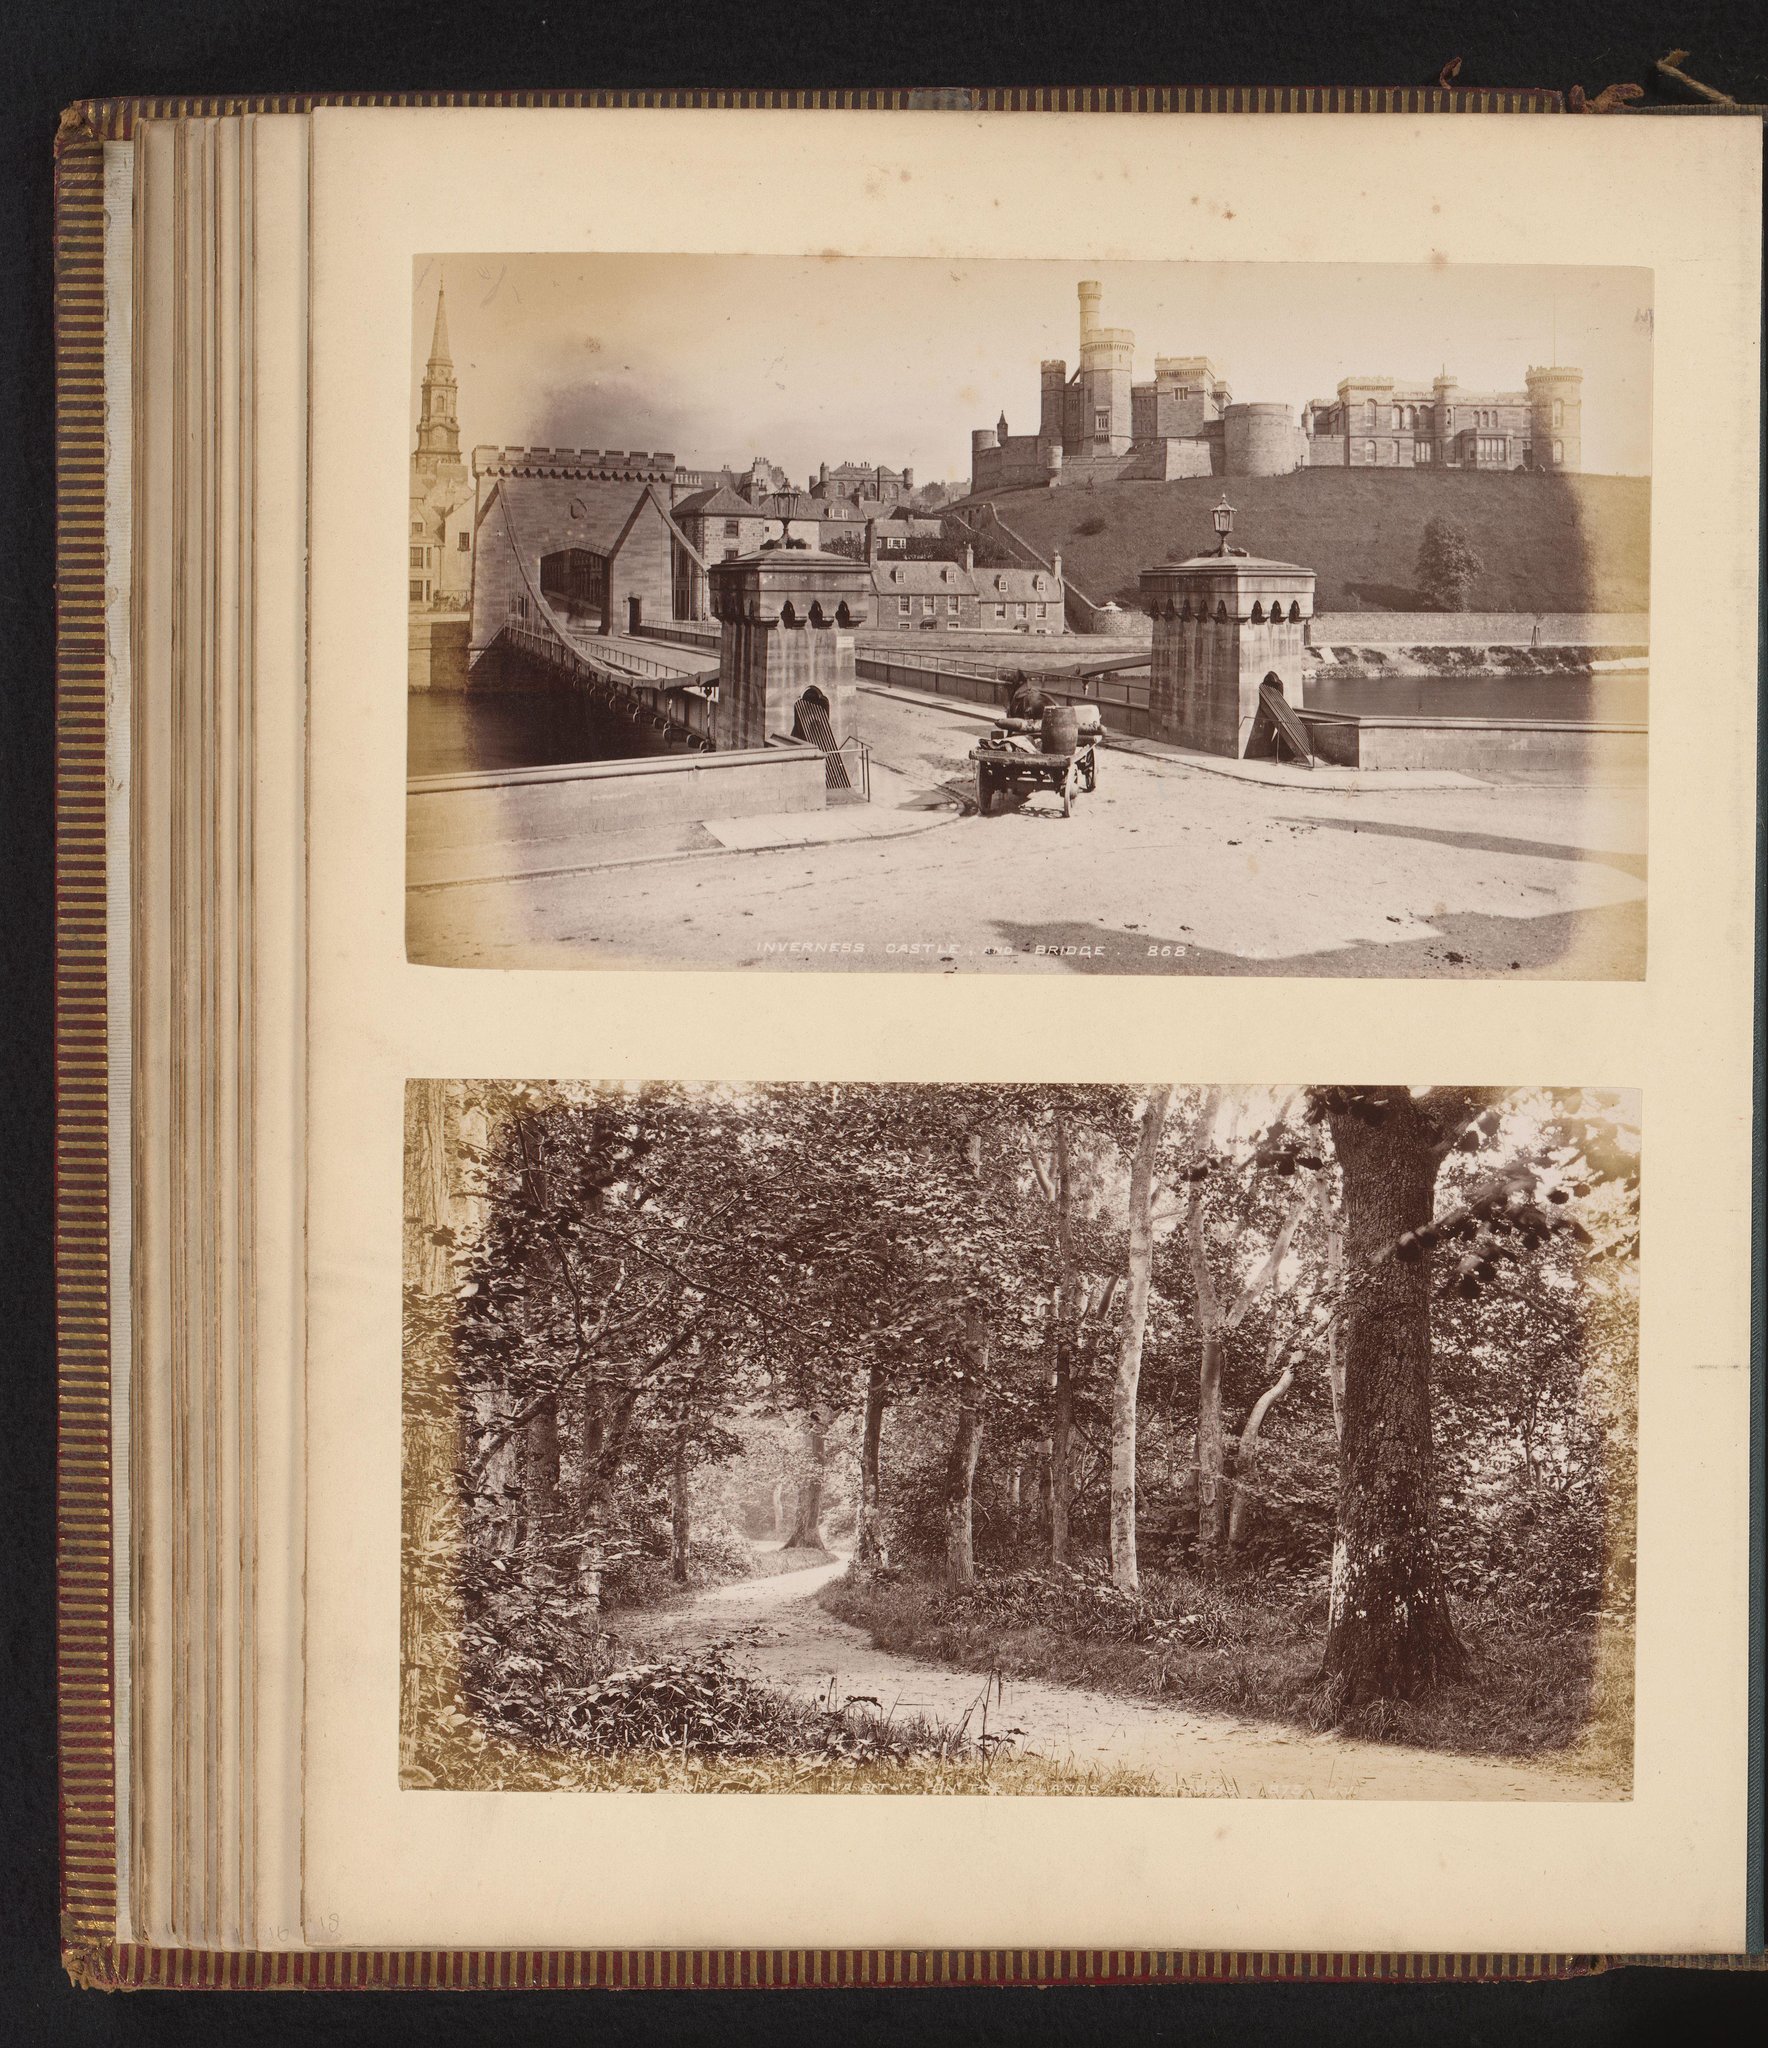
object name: album leaf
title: Inverness Castle en Gezicht op een bospad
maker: Anonymous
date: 1875-1885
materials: photographic support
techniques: albumen print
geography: inverness castle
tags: castle, forest path or lane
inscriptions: number: ‘808, J.V.’, number: ‘875, J.V.’